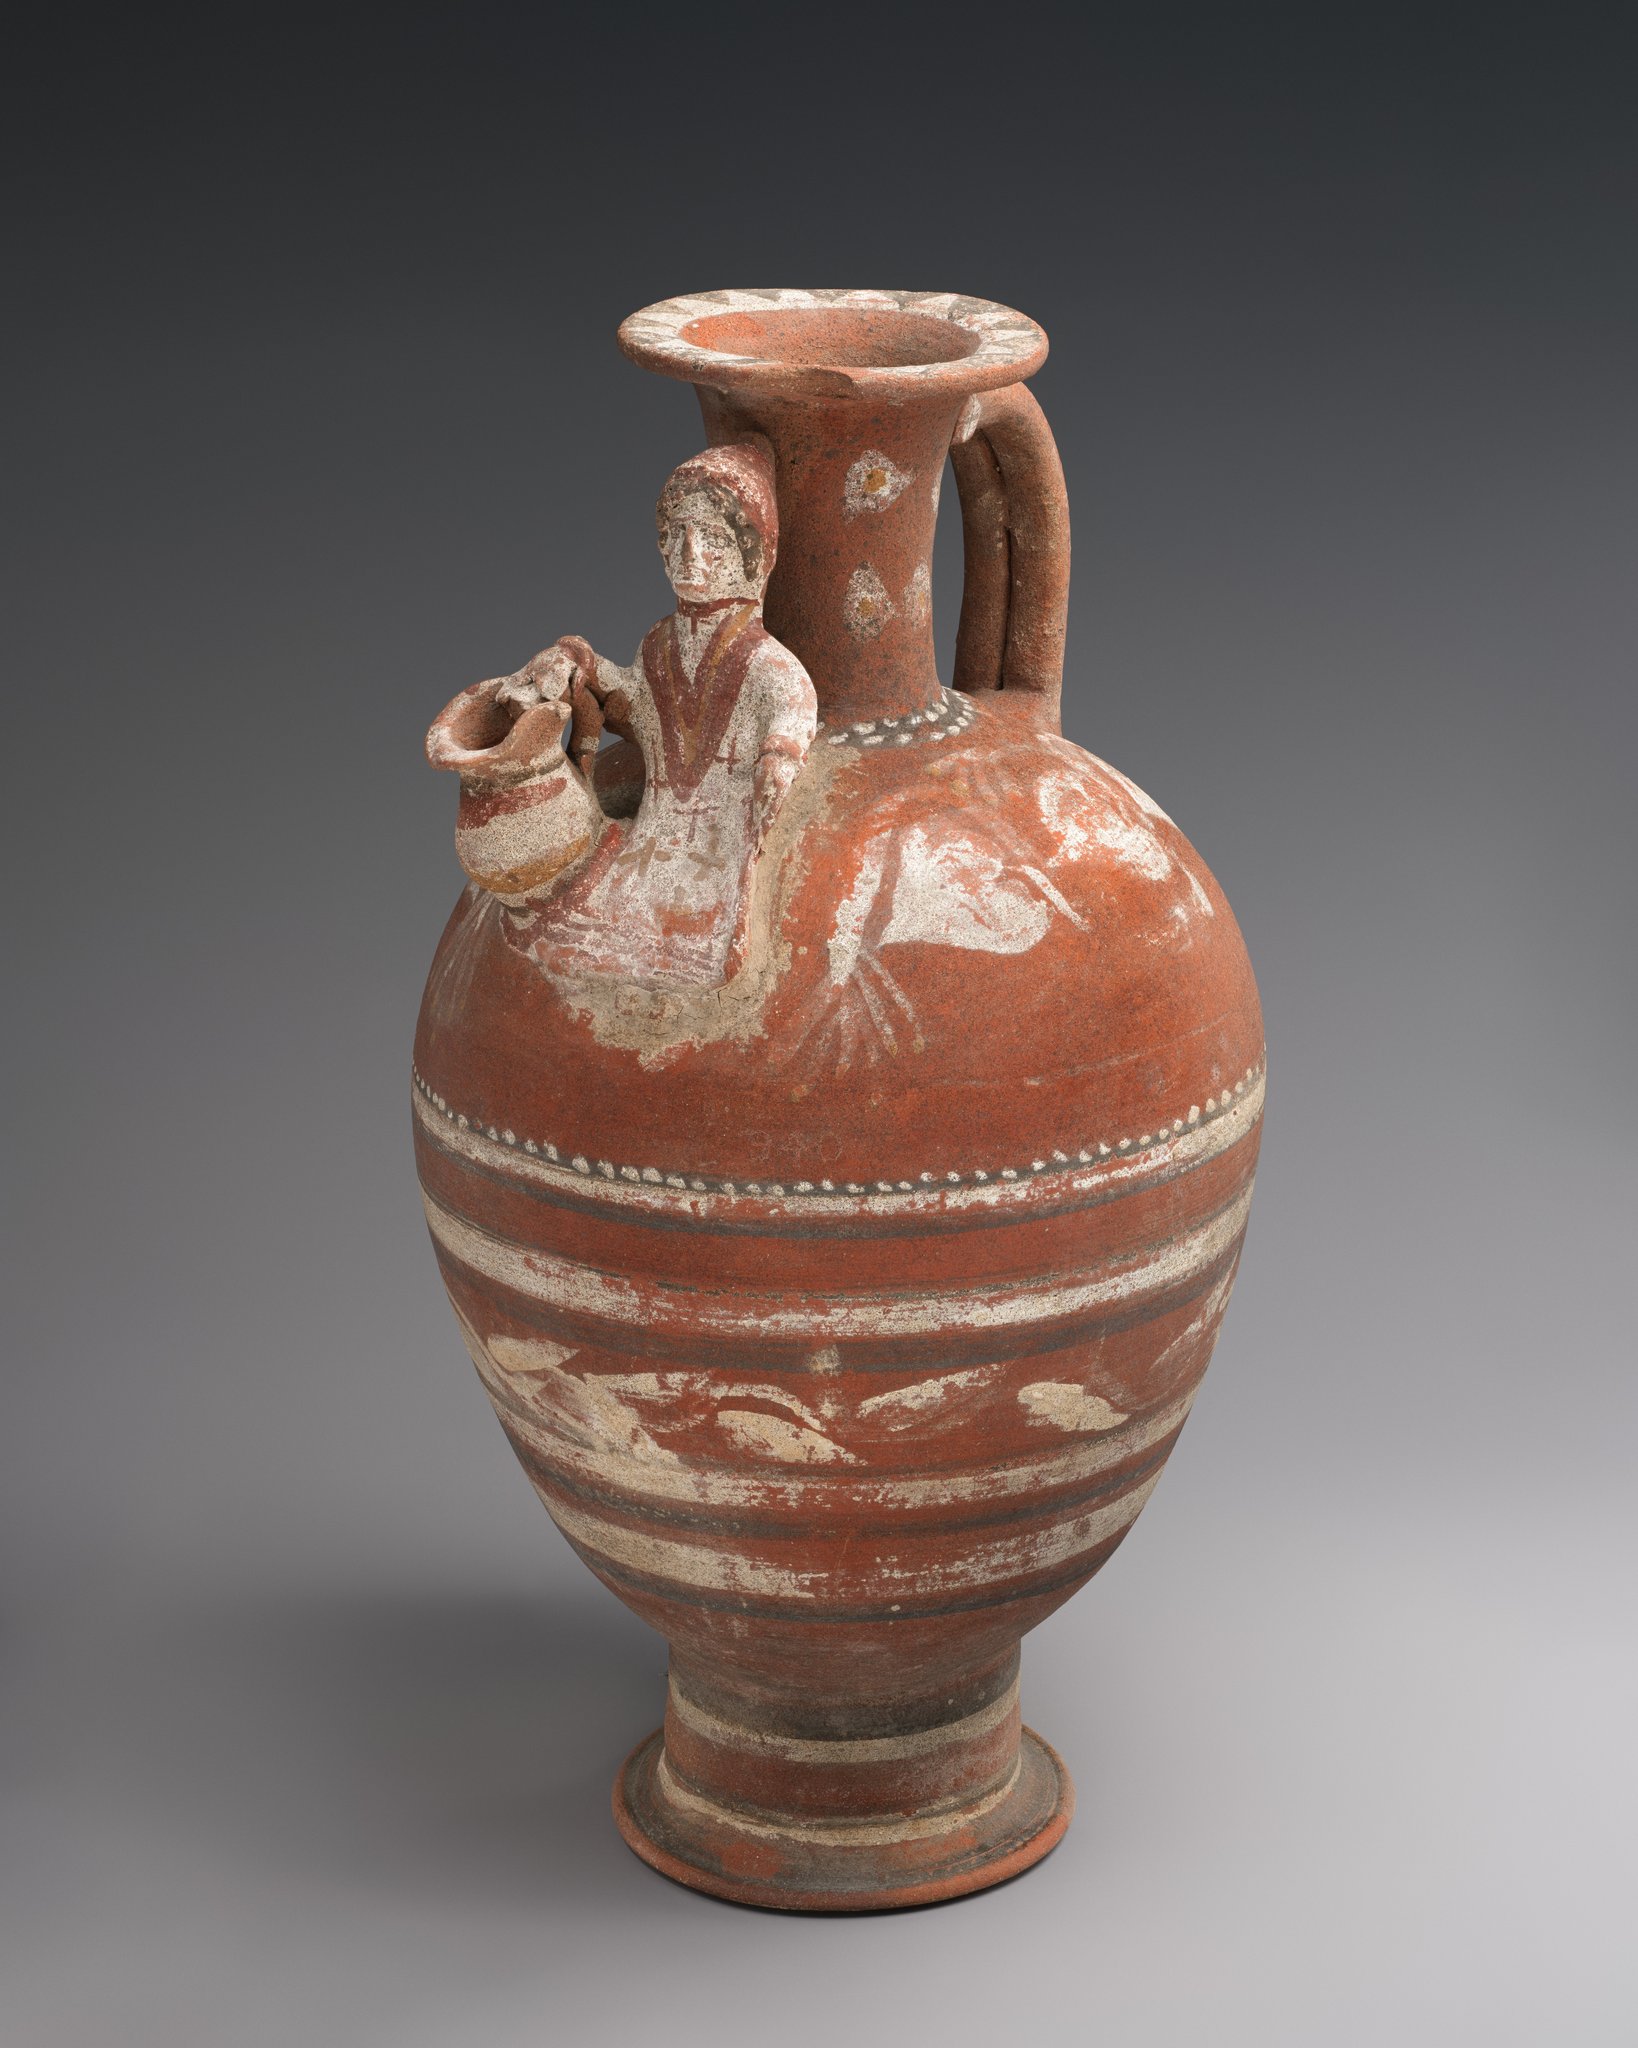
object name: jug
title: Terracotta jug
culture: cypriot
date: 400-323 BCE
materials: terracotta